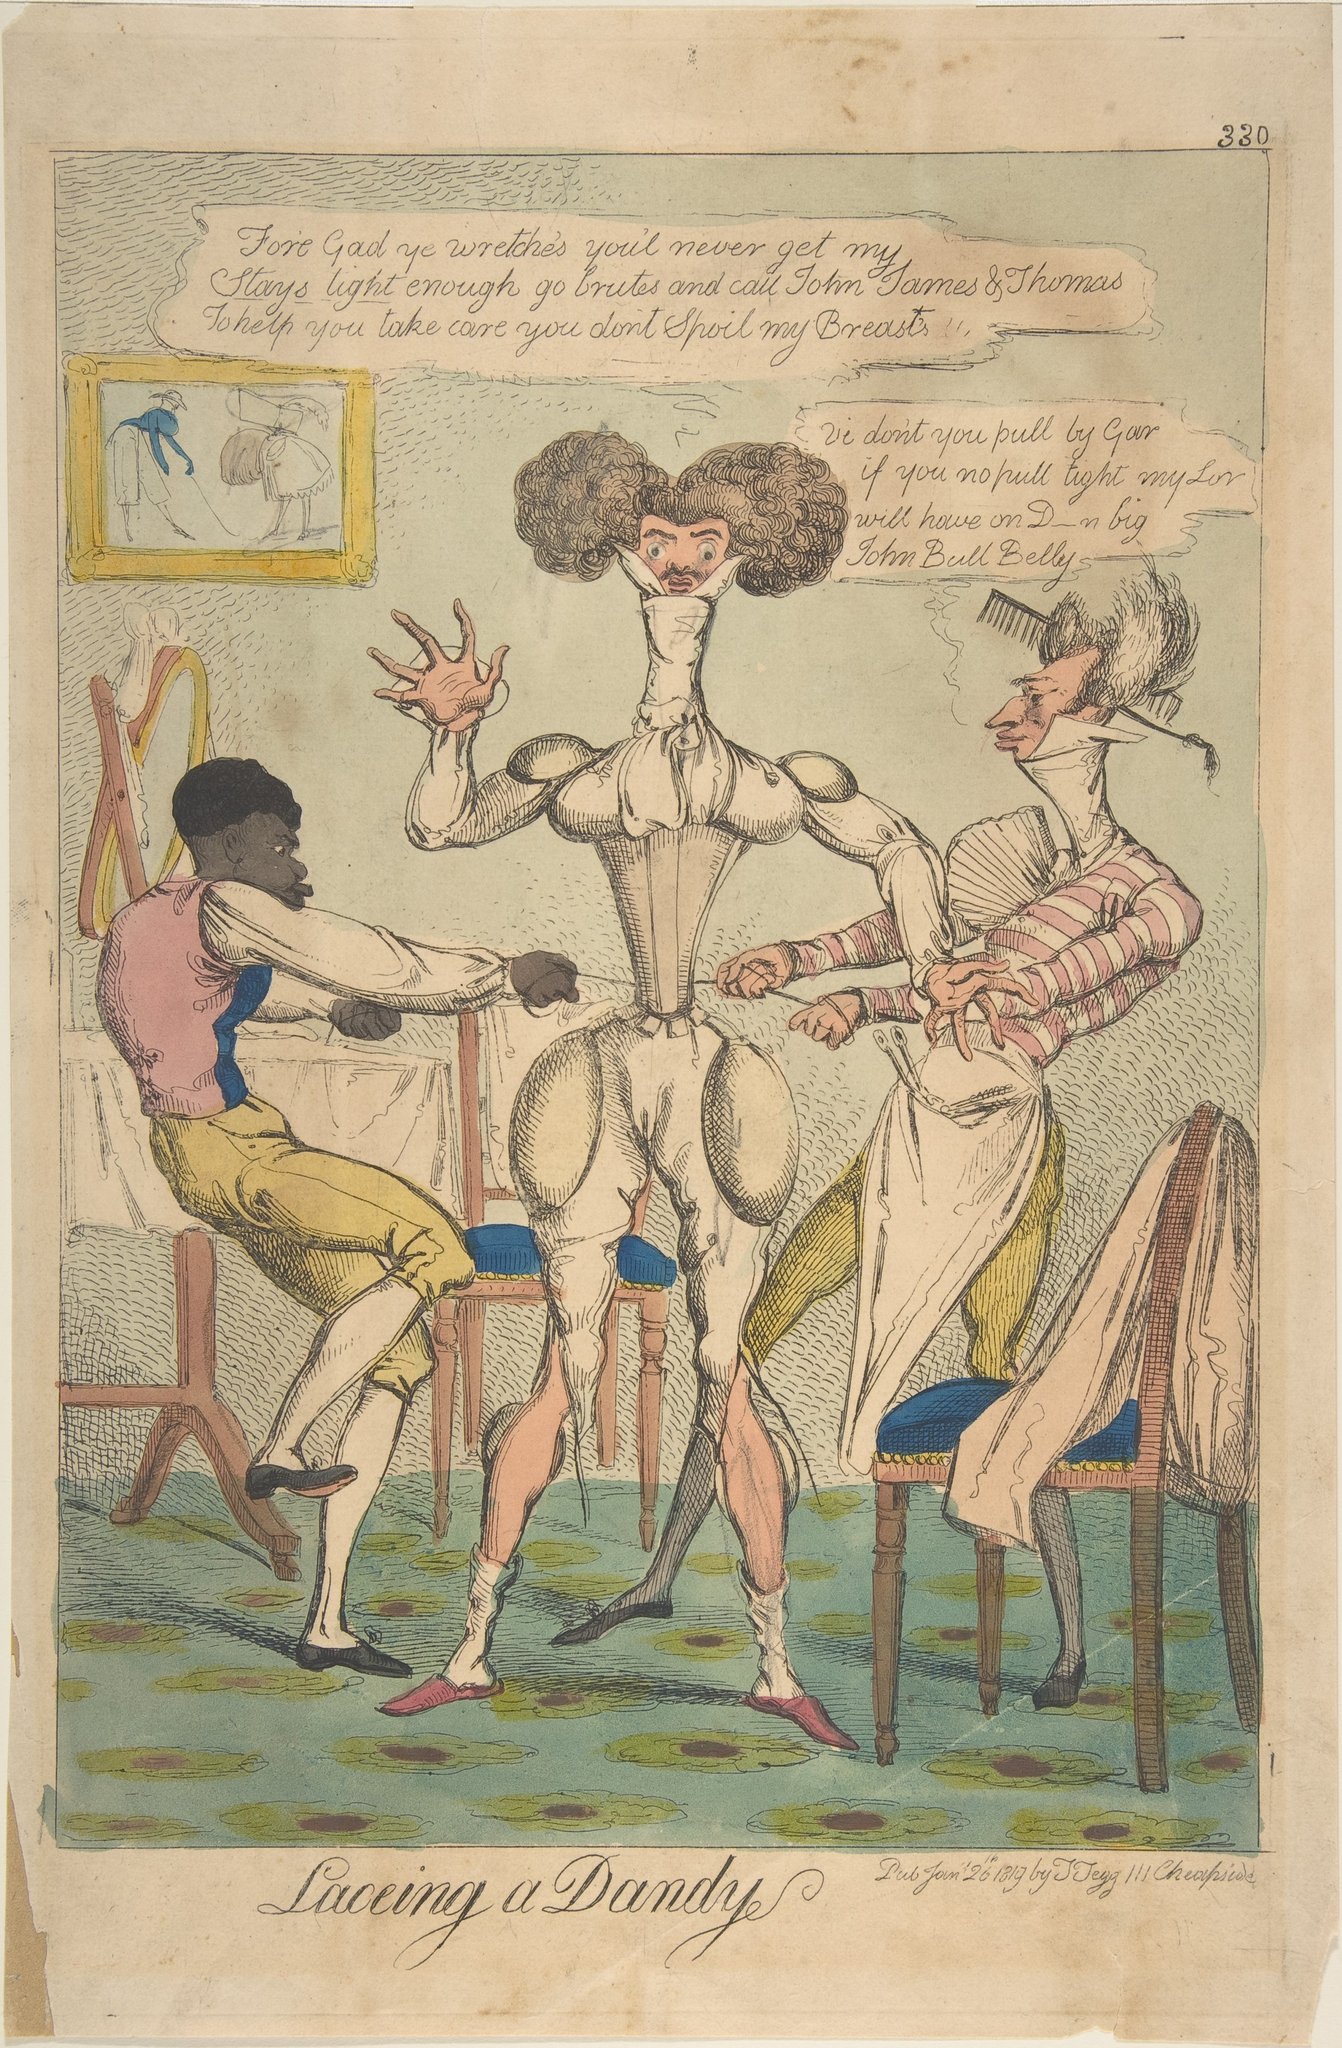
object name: print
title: Laceing [sic] a Dandy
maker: anonymous, british, 19th century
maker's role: artist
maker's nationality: british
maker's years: 1800-1900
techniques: etching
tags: satire,men,dressing,fashion,caricature